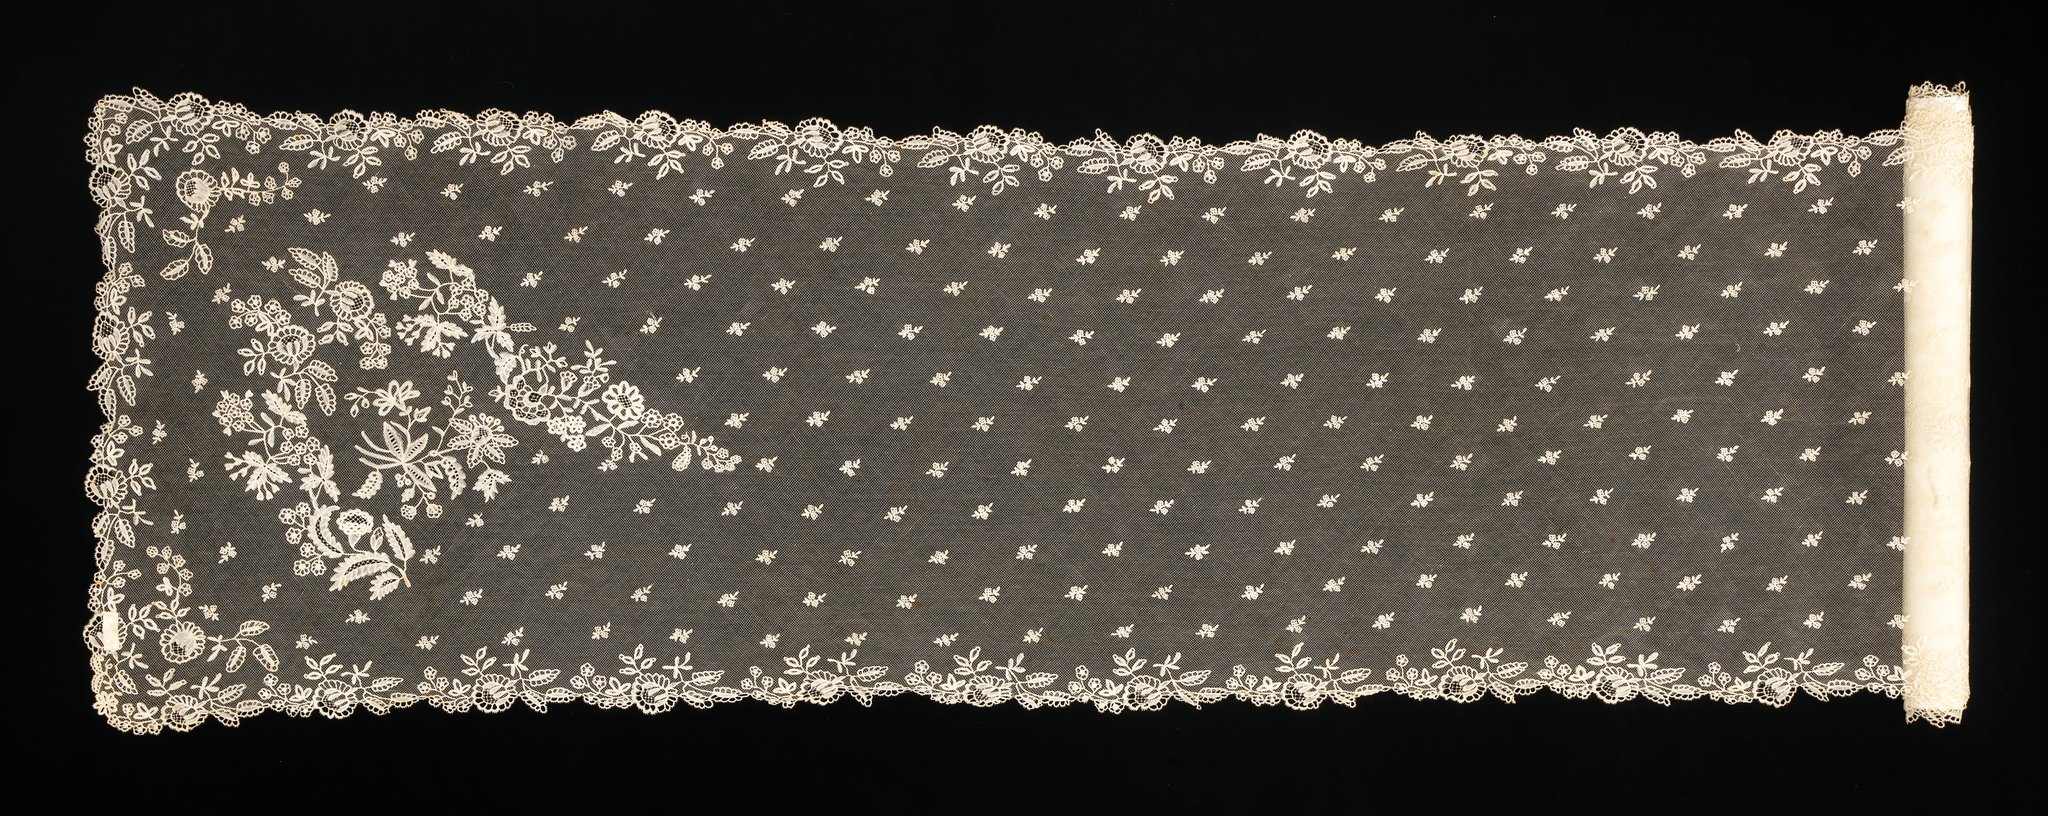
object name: stole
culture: european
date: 1830-1850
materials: linen, silk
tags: flowers